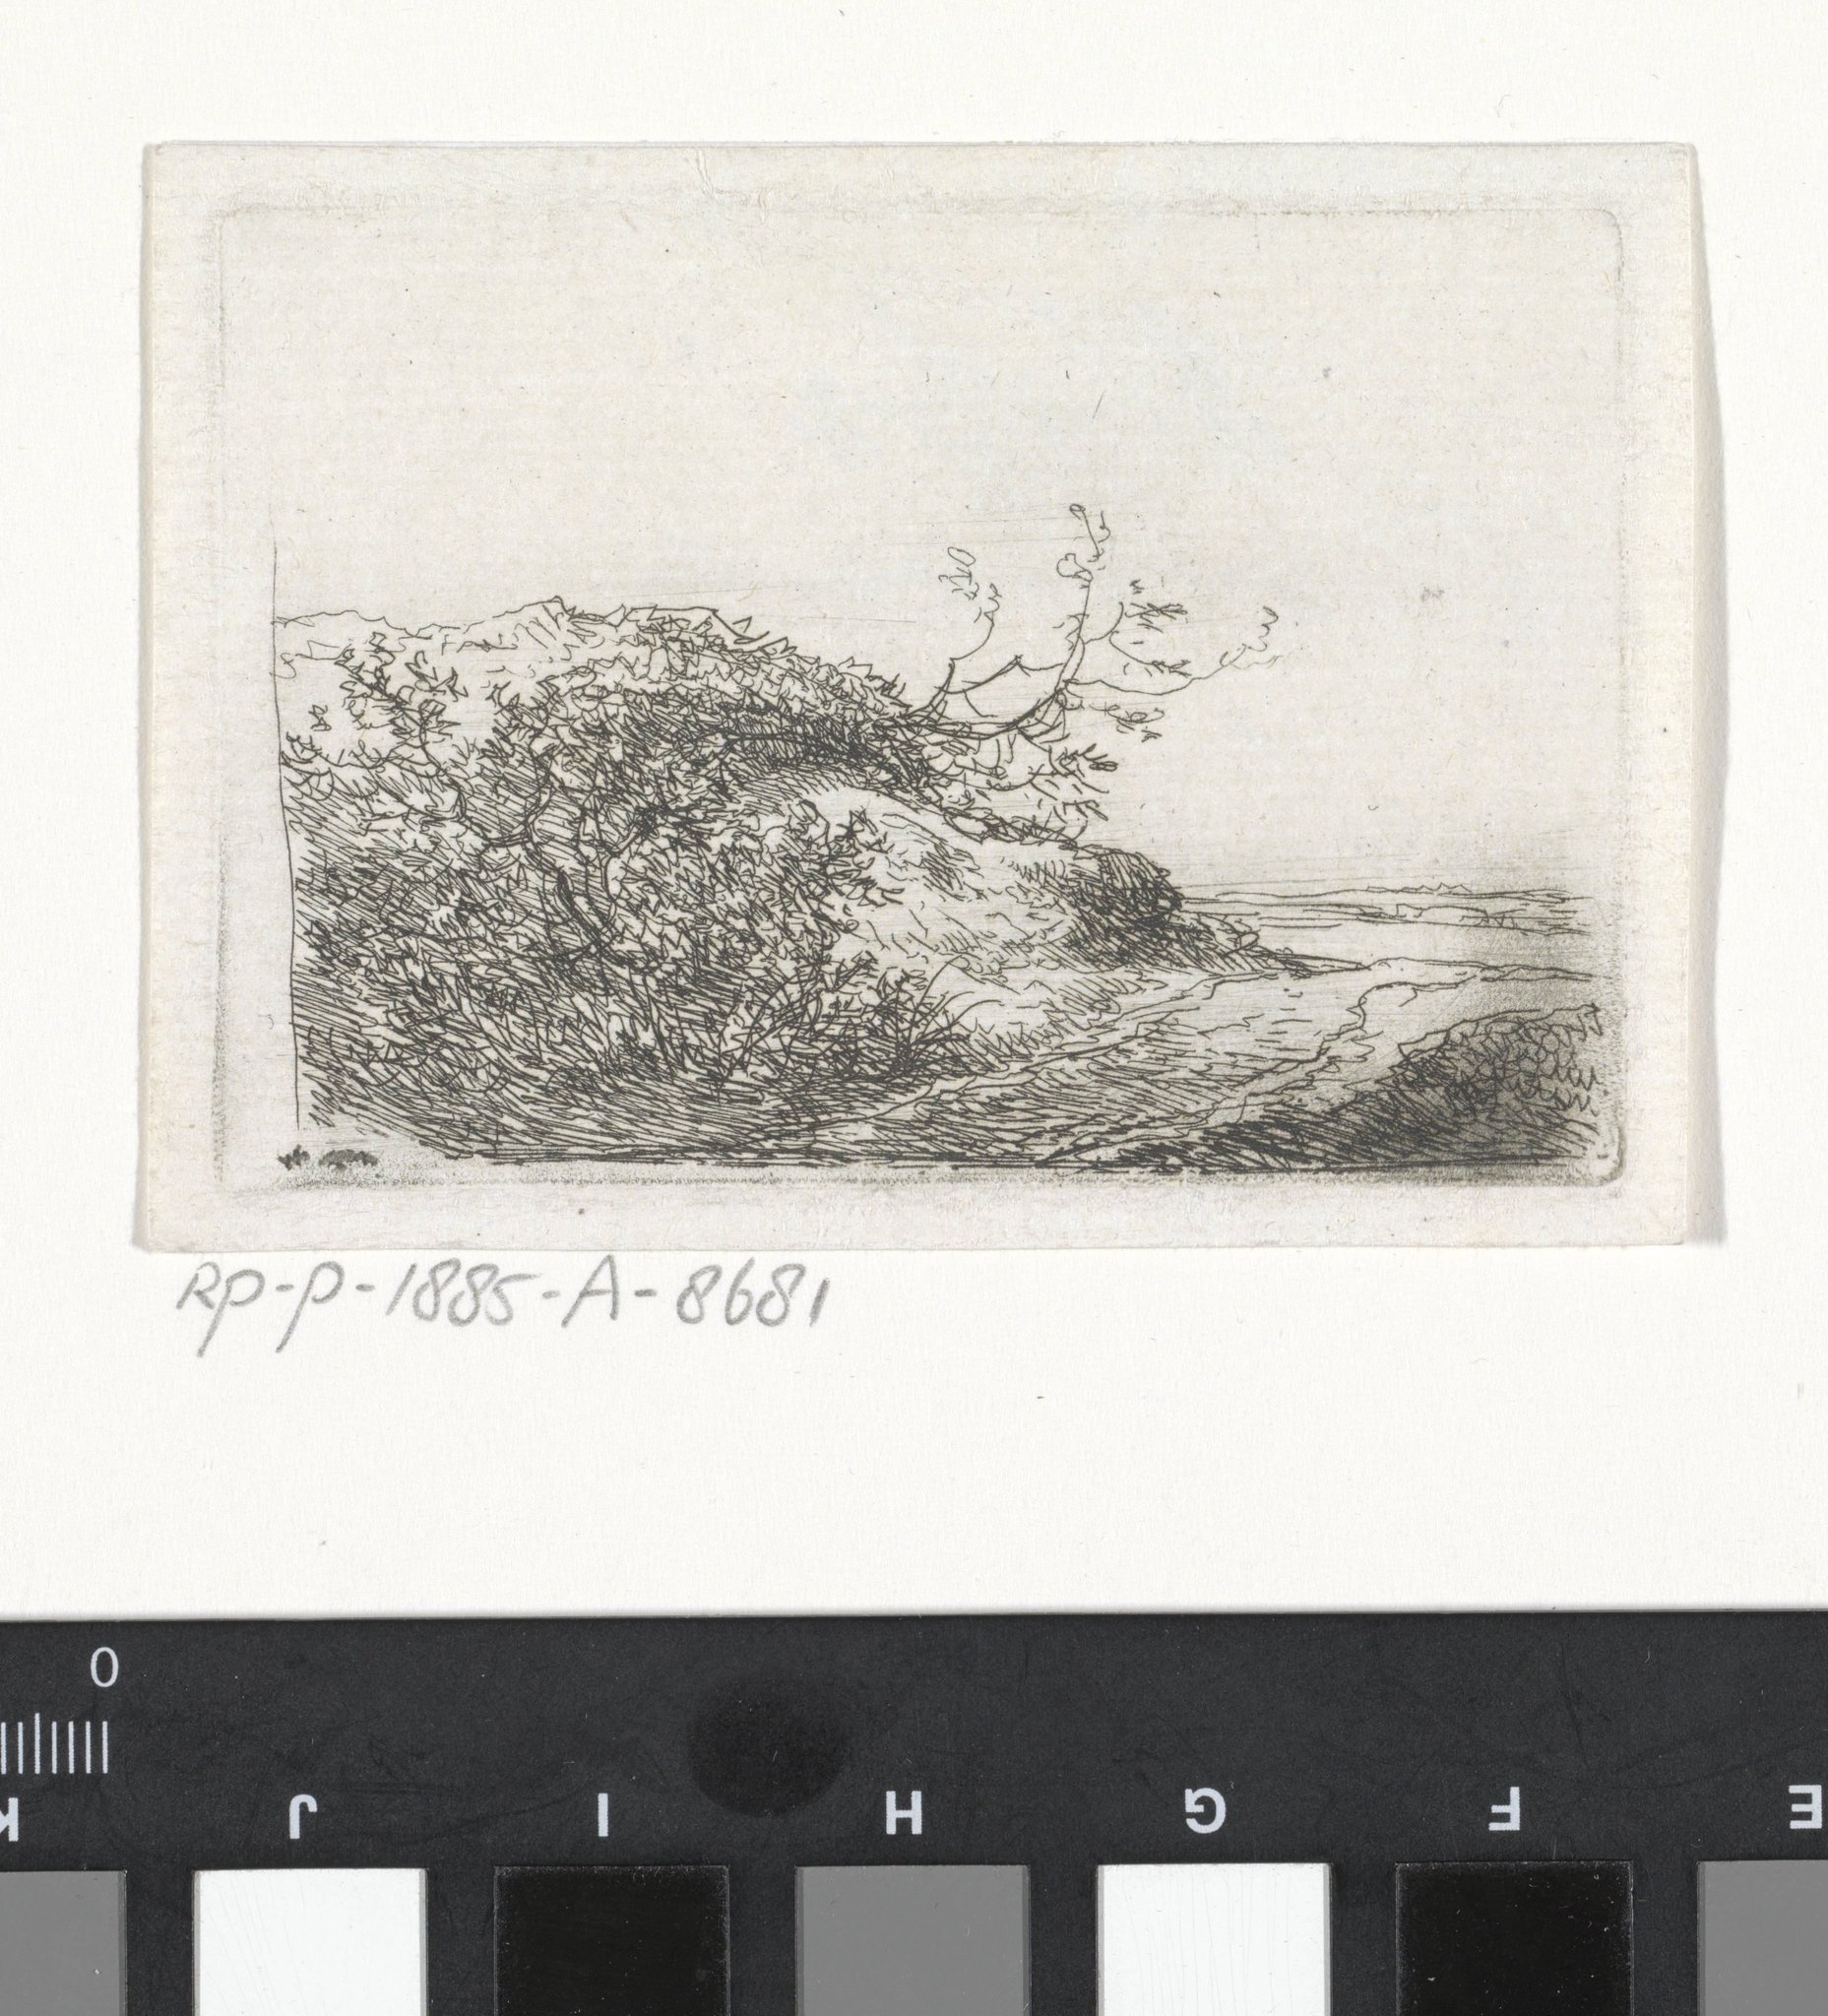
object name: print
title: Weg langs een duin met struiken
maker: Anonymous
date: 1700-1885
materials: paper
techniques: etching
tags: dunes (sea not visible); in the dunes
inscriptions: collector's mark: Lugt 2228, collector's mark: Lugt 2610